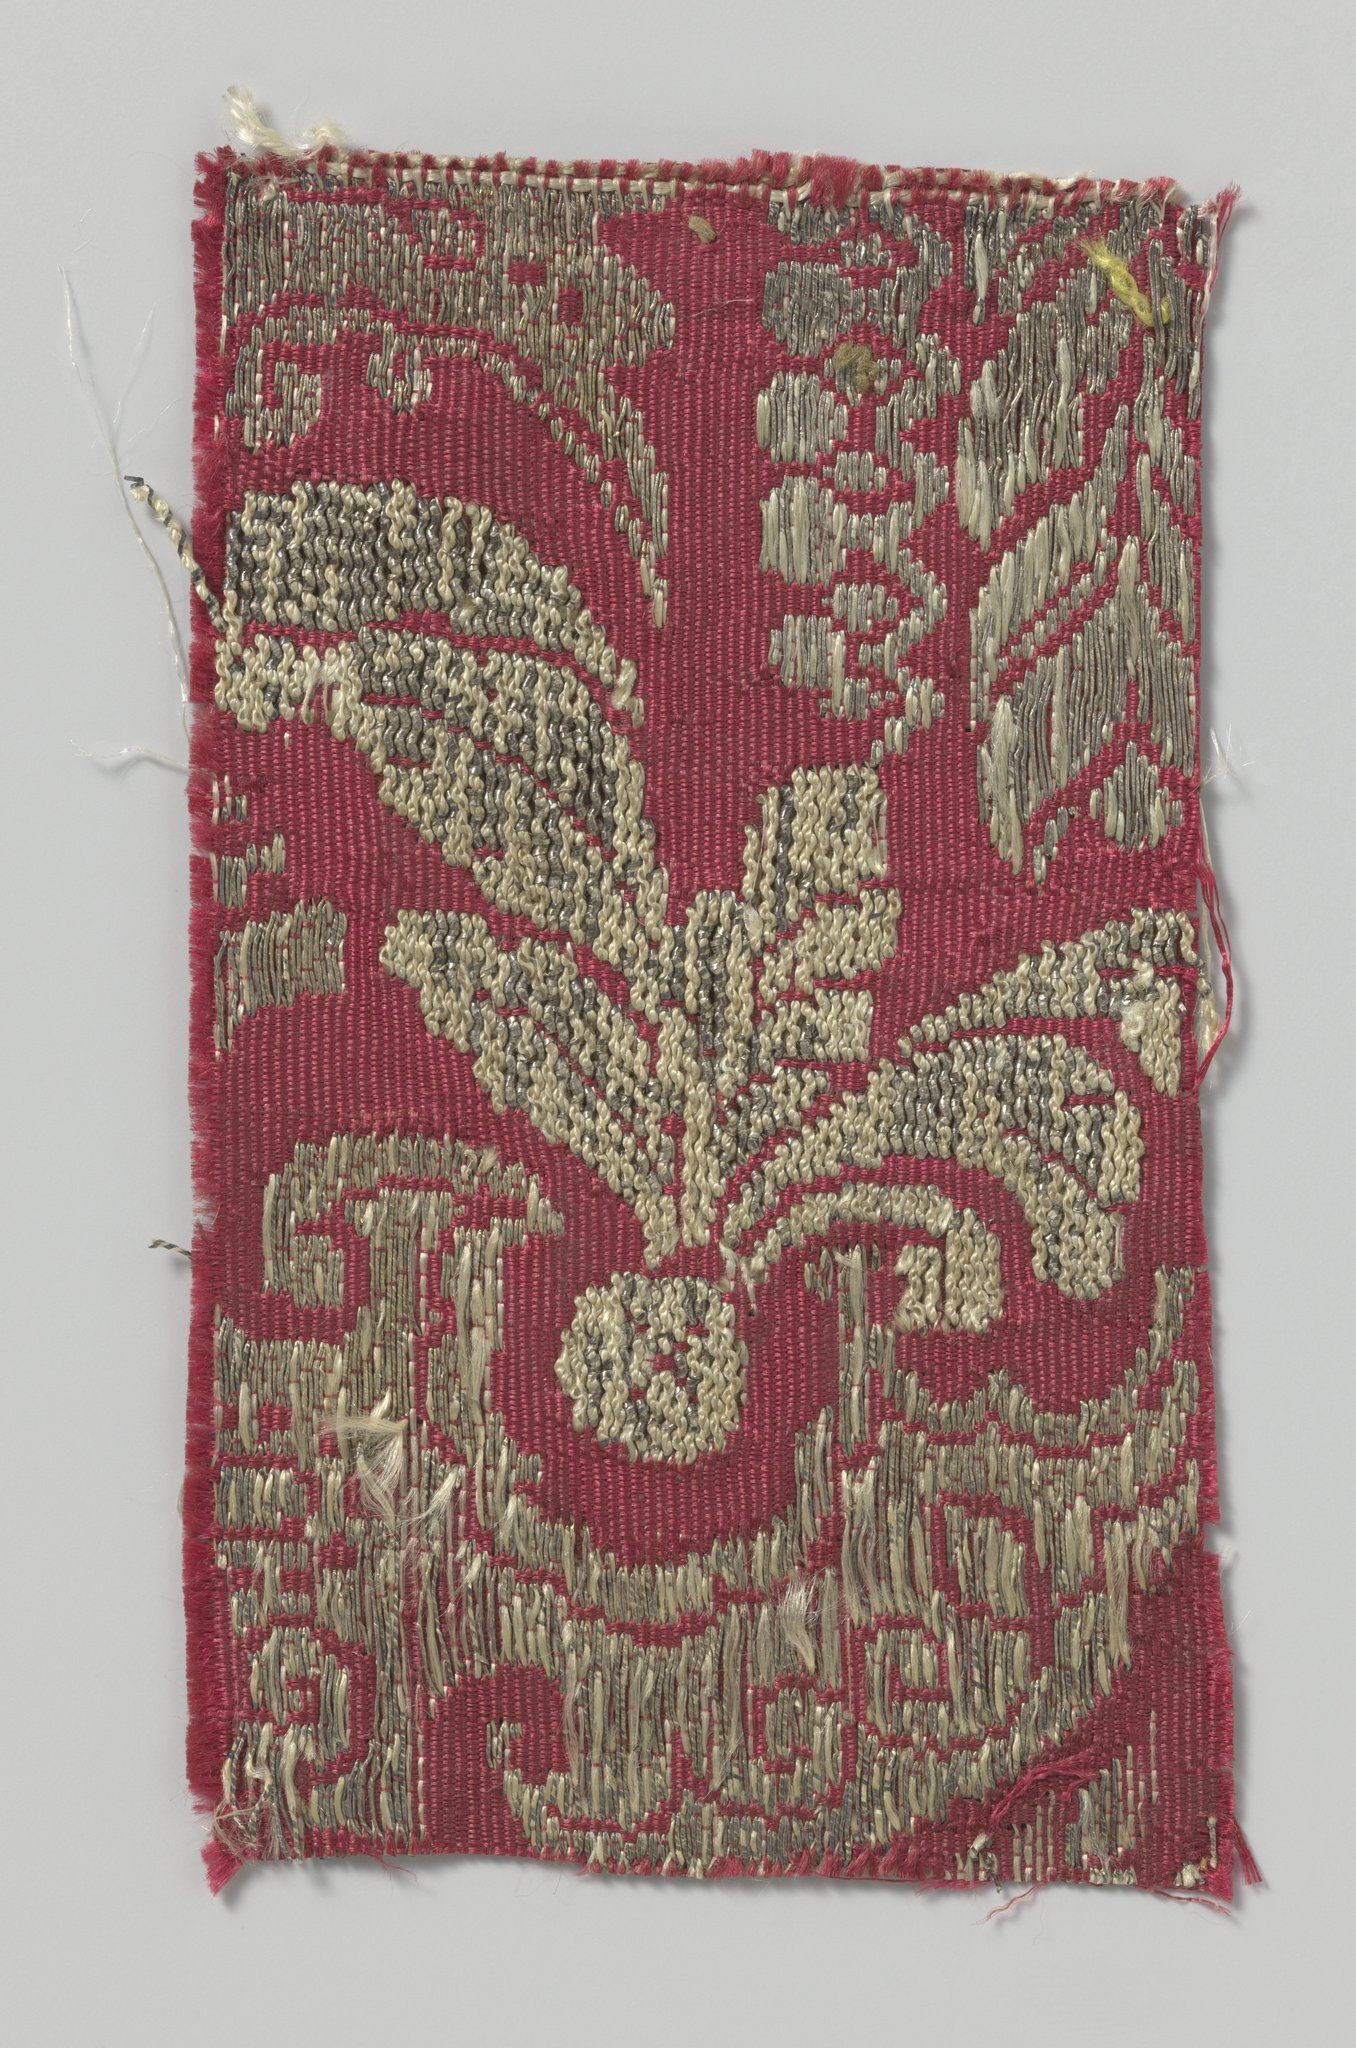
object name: woven material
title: Fragment van rode zijde met patroon in goud- en zilverdraad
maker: Anonymous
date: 1600-1699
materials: silk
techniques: lampas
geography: netherlands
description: Fragment van rode zijde met een patroon in keper van gebrocheerd goud- en zilverdraad, waarschijnlijk in de vorm van cartouches, gevuld met vederpluim-vormige figuren, en omgegeven door brede ornamentbanden.